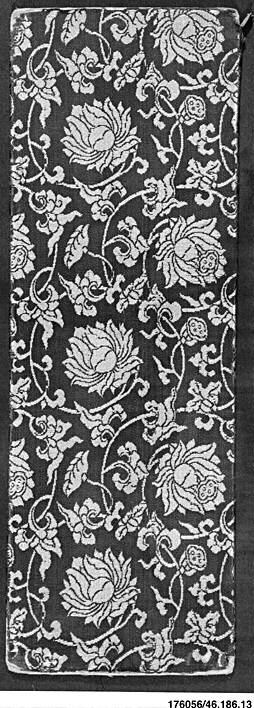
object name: sutra cover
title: Sutra Cover with Lotus Scroll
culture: chinese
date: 1501-1600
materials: silk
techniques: patterning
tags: lotuses,leaves